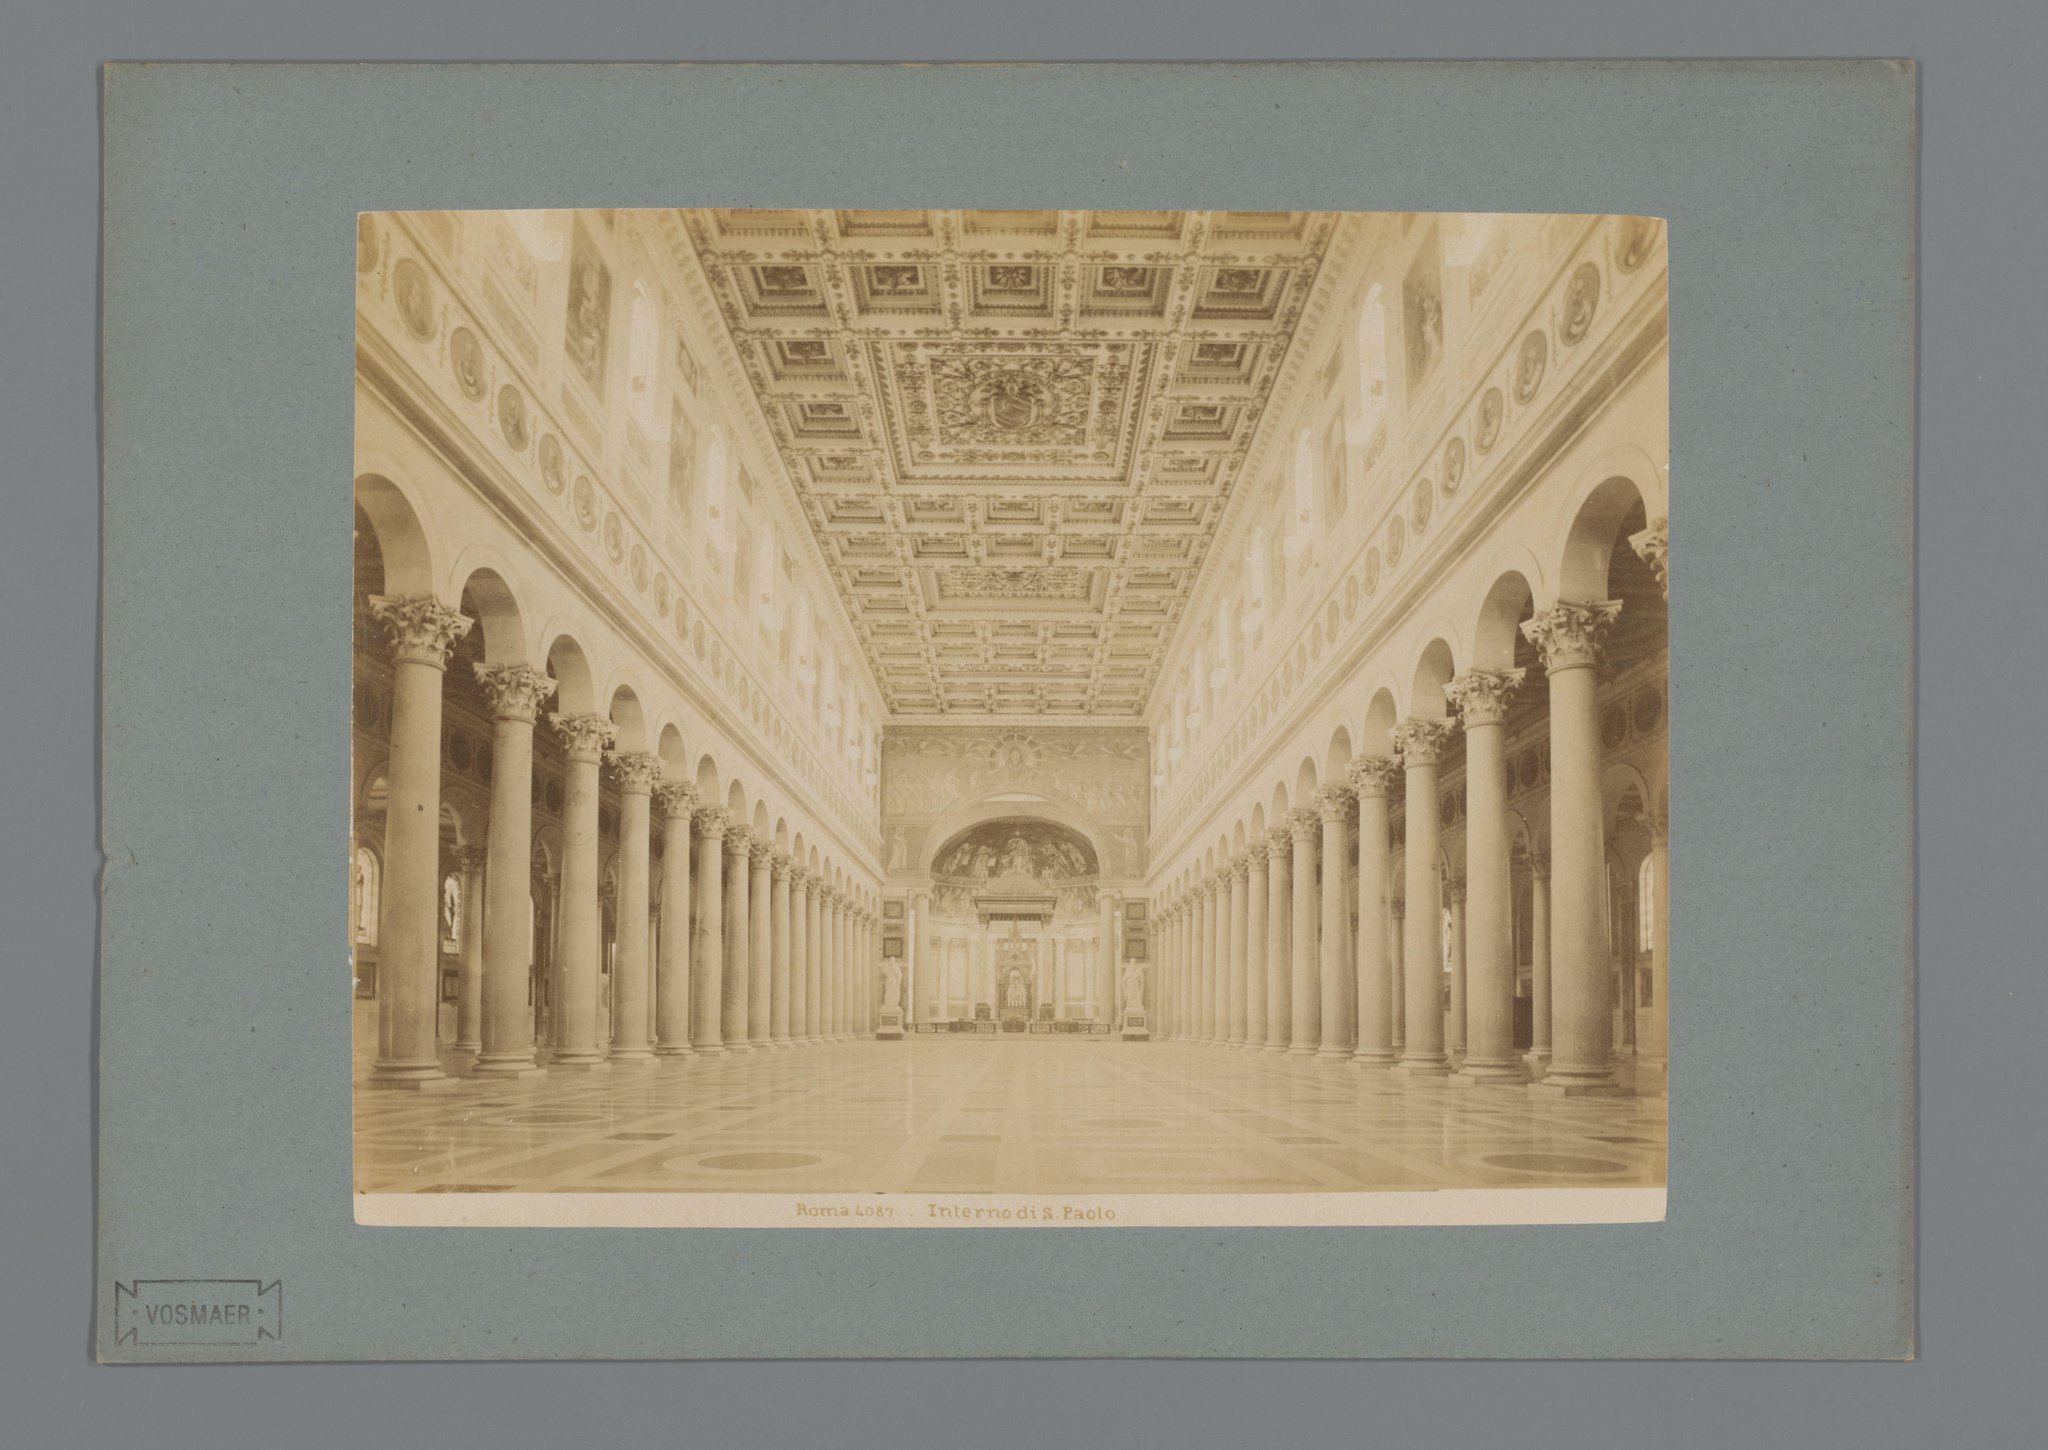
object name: photograph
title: Interieur van de Sint-Paulus buiten de Muren te Rome, Italië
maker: Anonymous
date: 1851-1890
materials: cardboard, paper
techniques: albumen print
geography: rome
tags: interior of church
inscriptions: number: ‘4087.’, collector's mark: ‘VOSMAER’